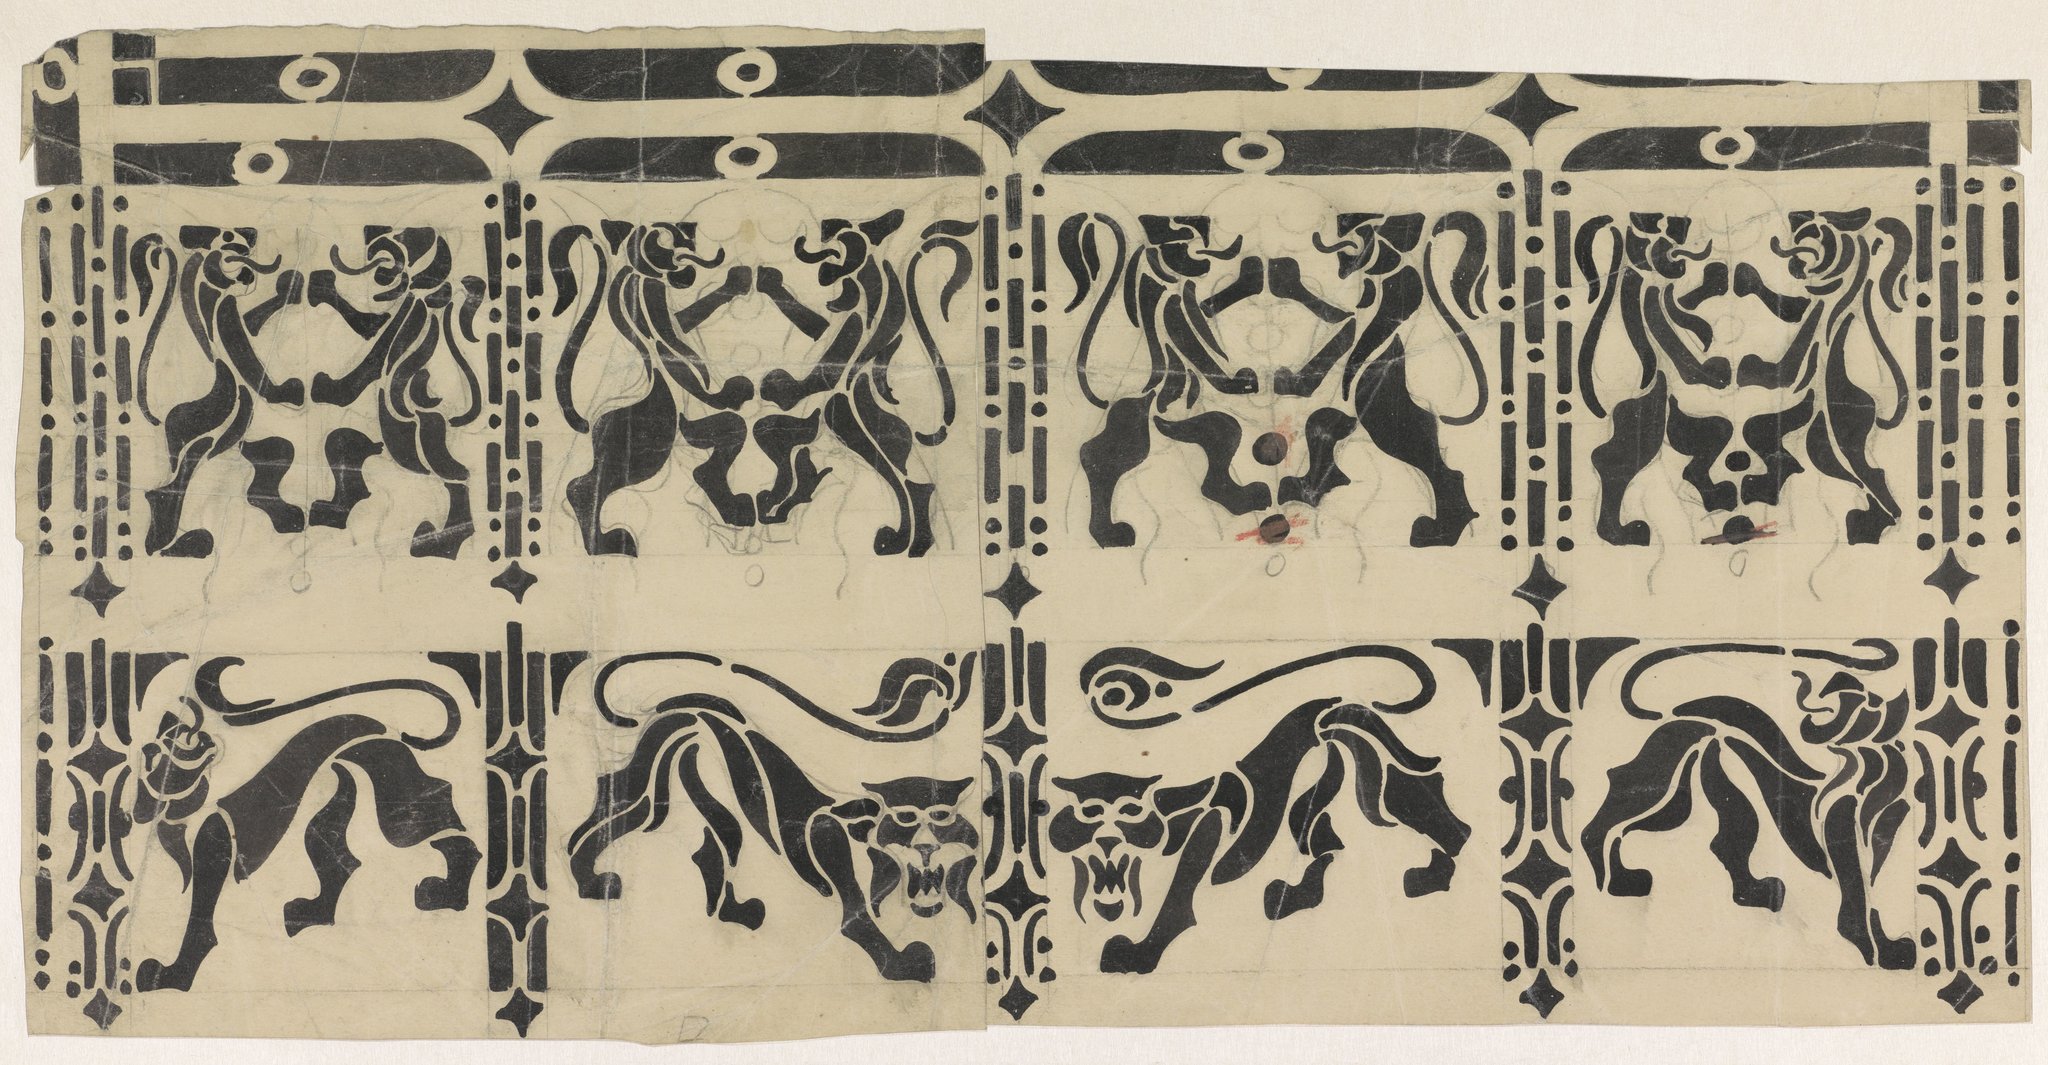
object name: drawing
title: Ontwerp met zes leeuwen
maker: carel adolph lion cachet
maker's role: draughtsman, print maker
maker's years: 1864-1945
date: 1874-1945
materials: paper, pencil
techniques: brush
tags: other ornament derived from animal forms, beasts of prey, predatory animals: lion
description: RP-T-1969-413 en RP-T-1969-414 passen aaneen.